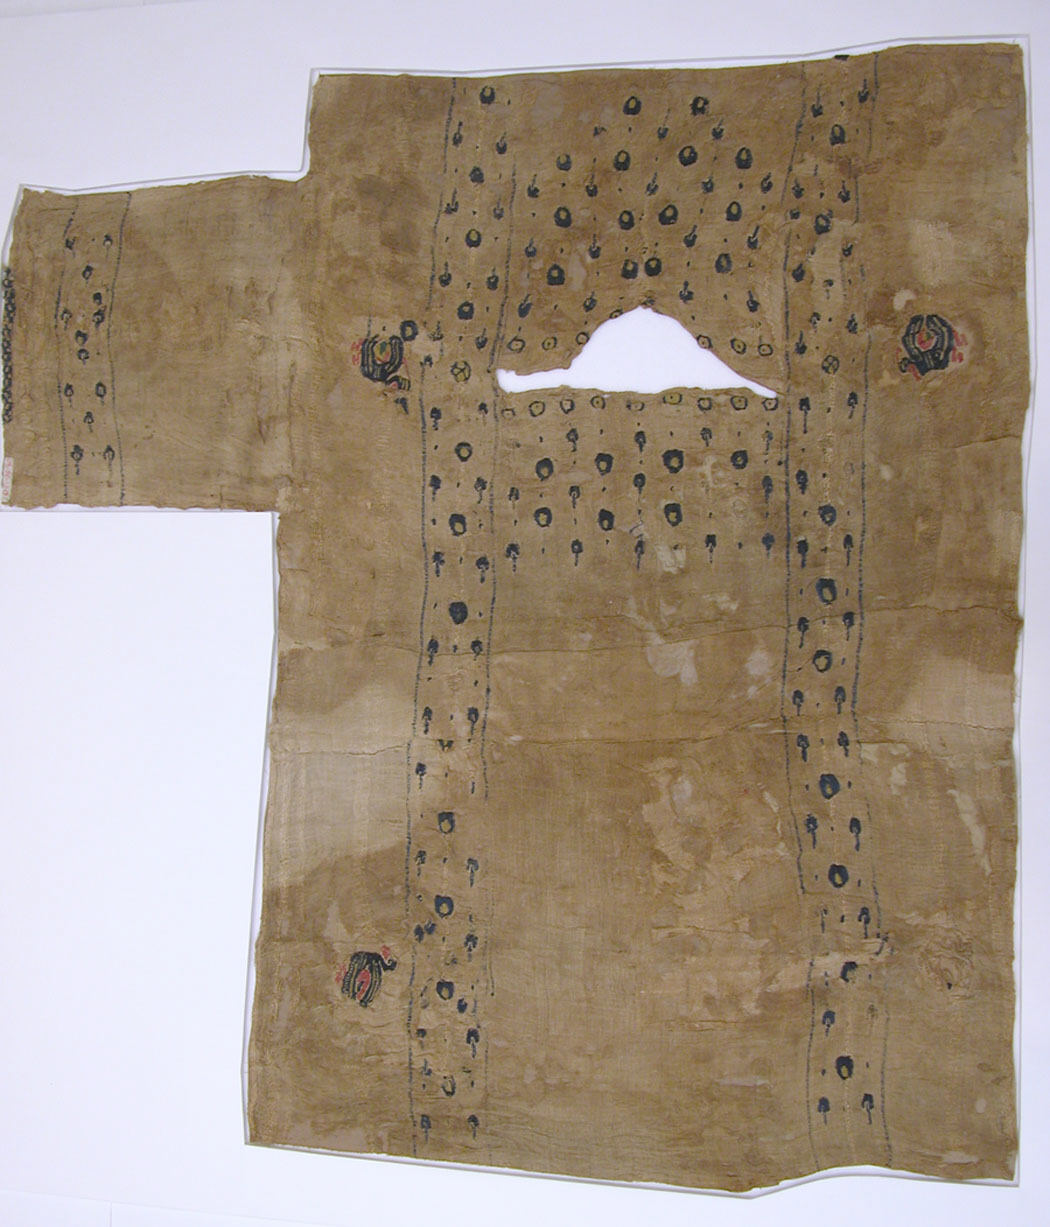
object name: tunic fragment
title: Fragment of a Tunic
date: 401-600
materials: linen, wool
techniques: weave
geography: egypt